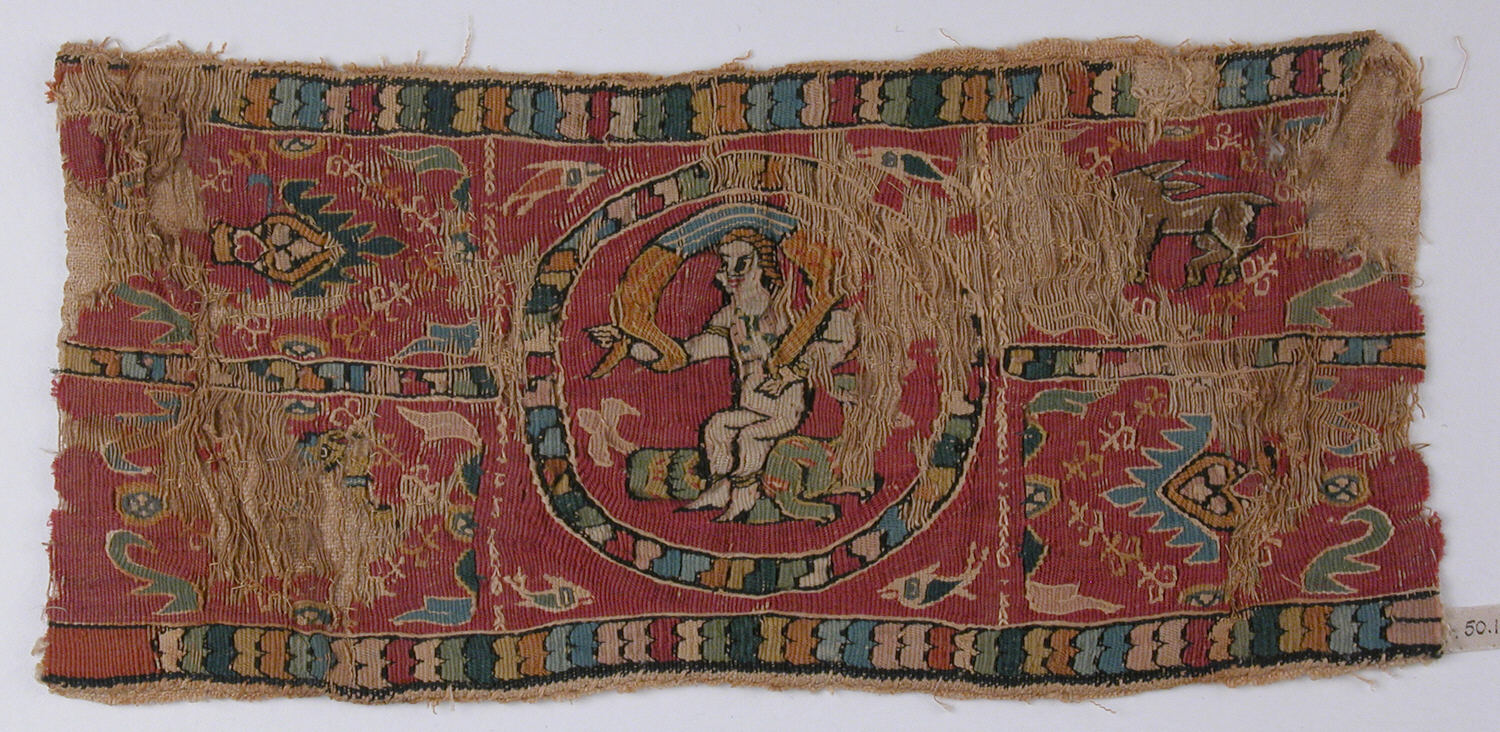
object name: band fragment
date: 501-700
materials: linen, wool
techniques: weave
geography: egypt